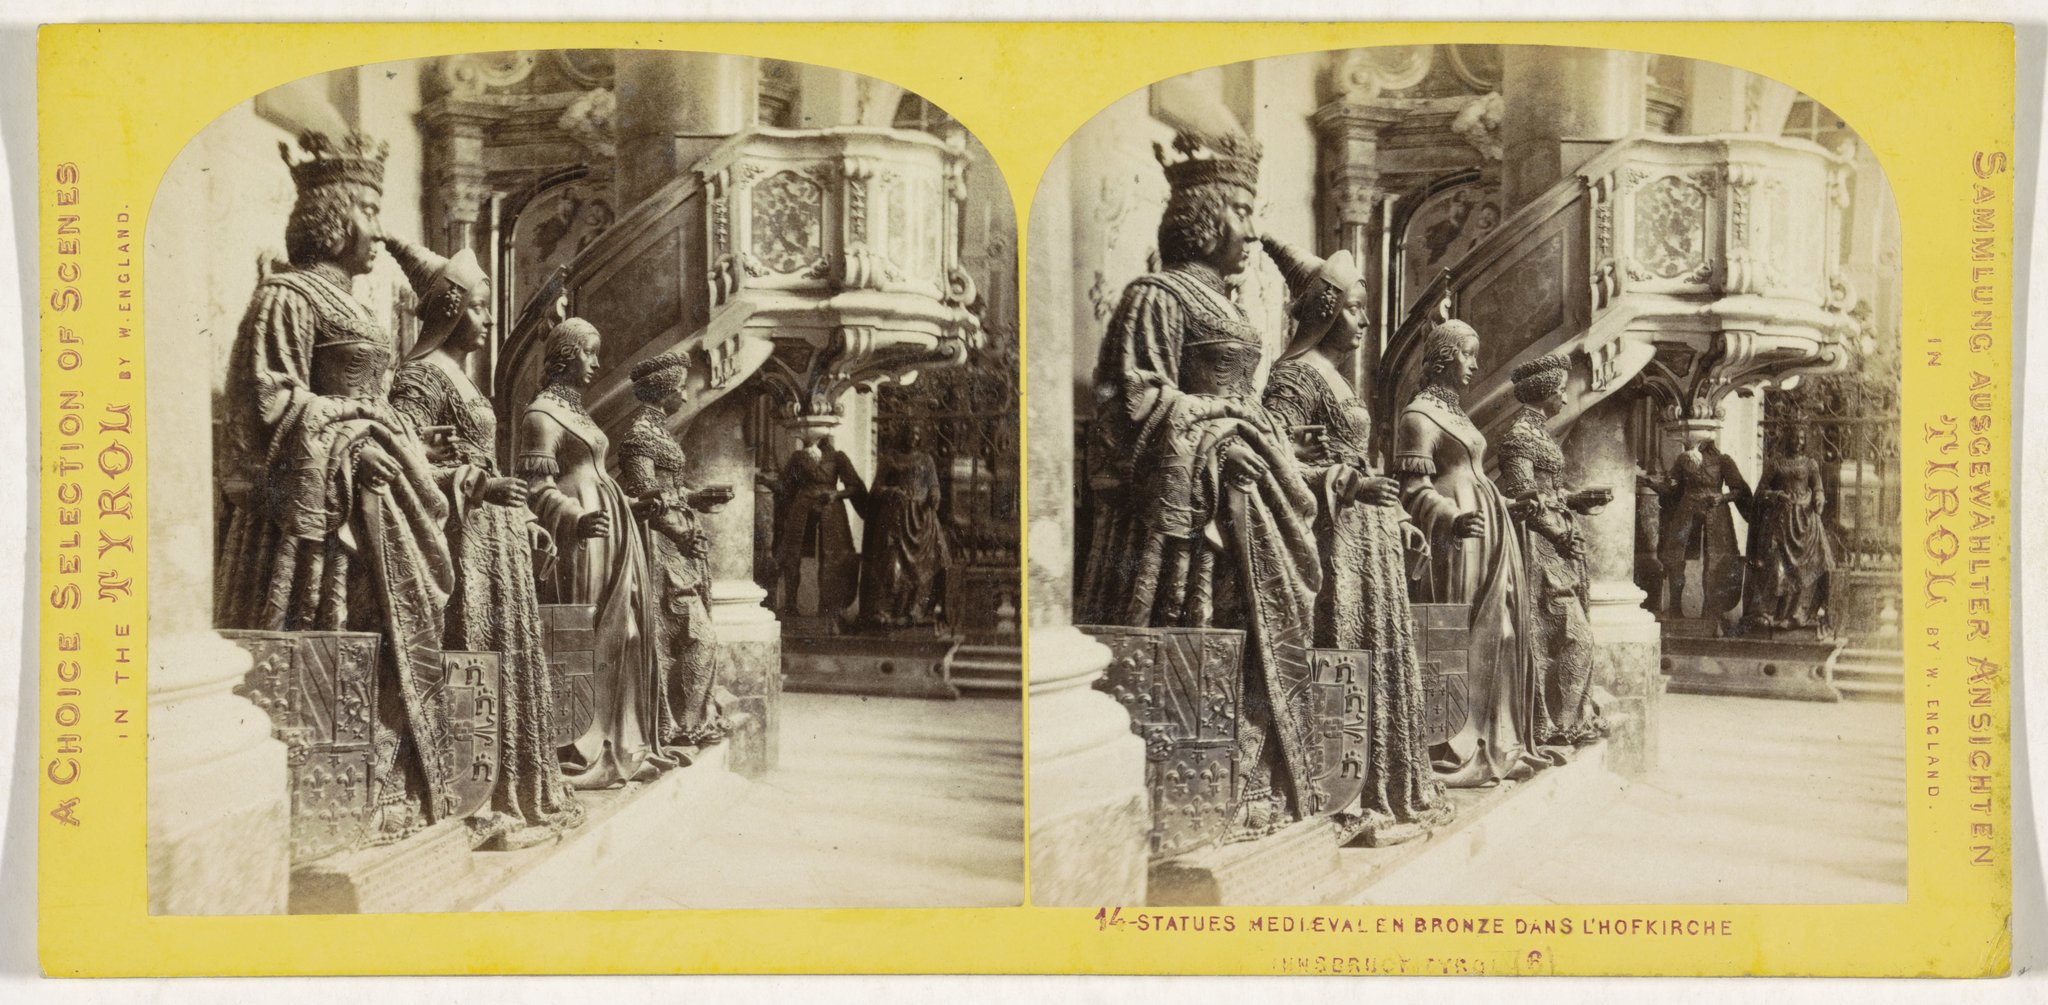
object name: stereograph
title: Statues mediæval en bronze dans l'Hofkirche, Innsbruck, Tyrol (6)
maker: william england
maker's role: fotograaf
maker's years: 1816-1896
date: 1863-1865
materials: cardboard, paper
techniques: albumen print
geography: innsbruck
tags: interior of church, sculpture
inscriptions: number: ‘14’